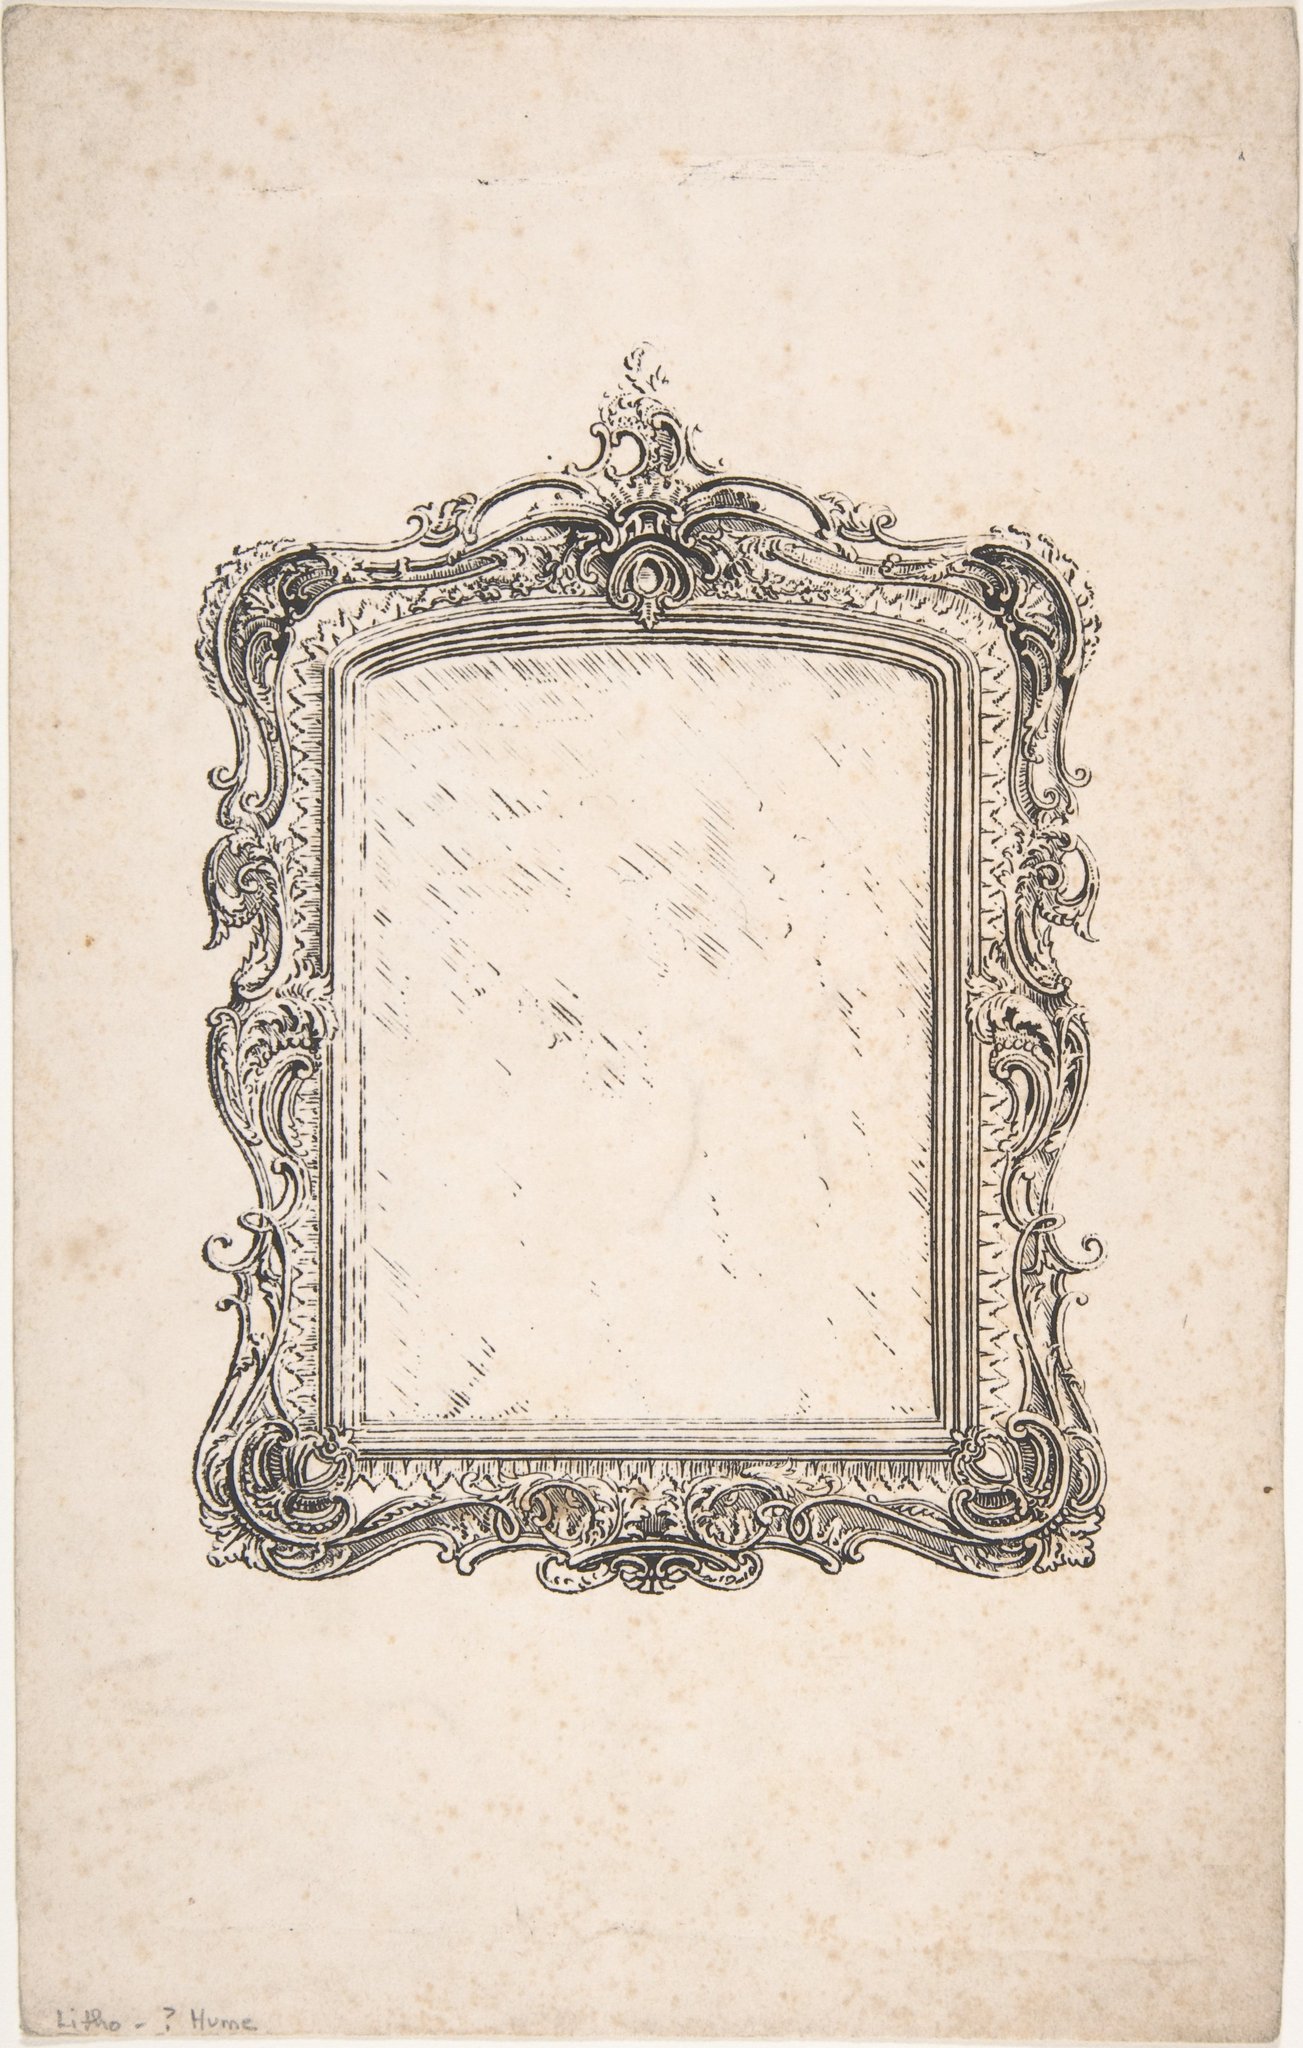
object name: drawing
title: Design for Frame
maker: robert william hume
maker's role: artist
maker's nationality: british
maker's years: 1816-1904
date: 1830-1900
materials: ink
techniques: pen